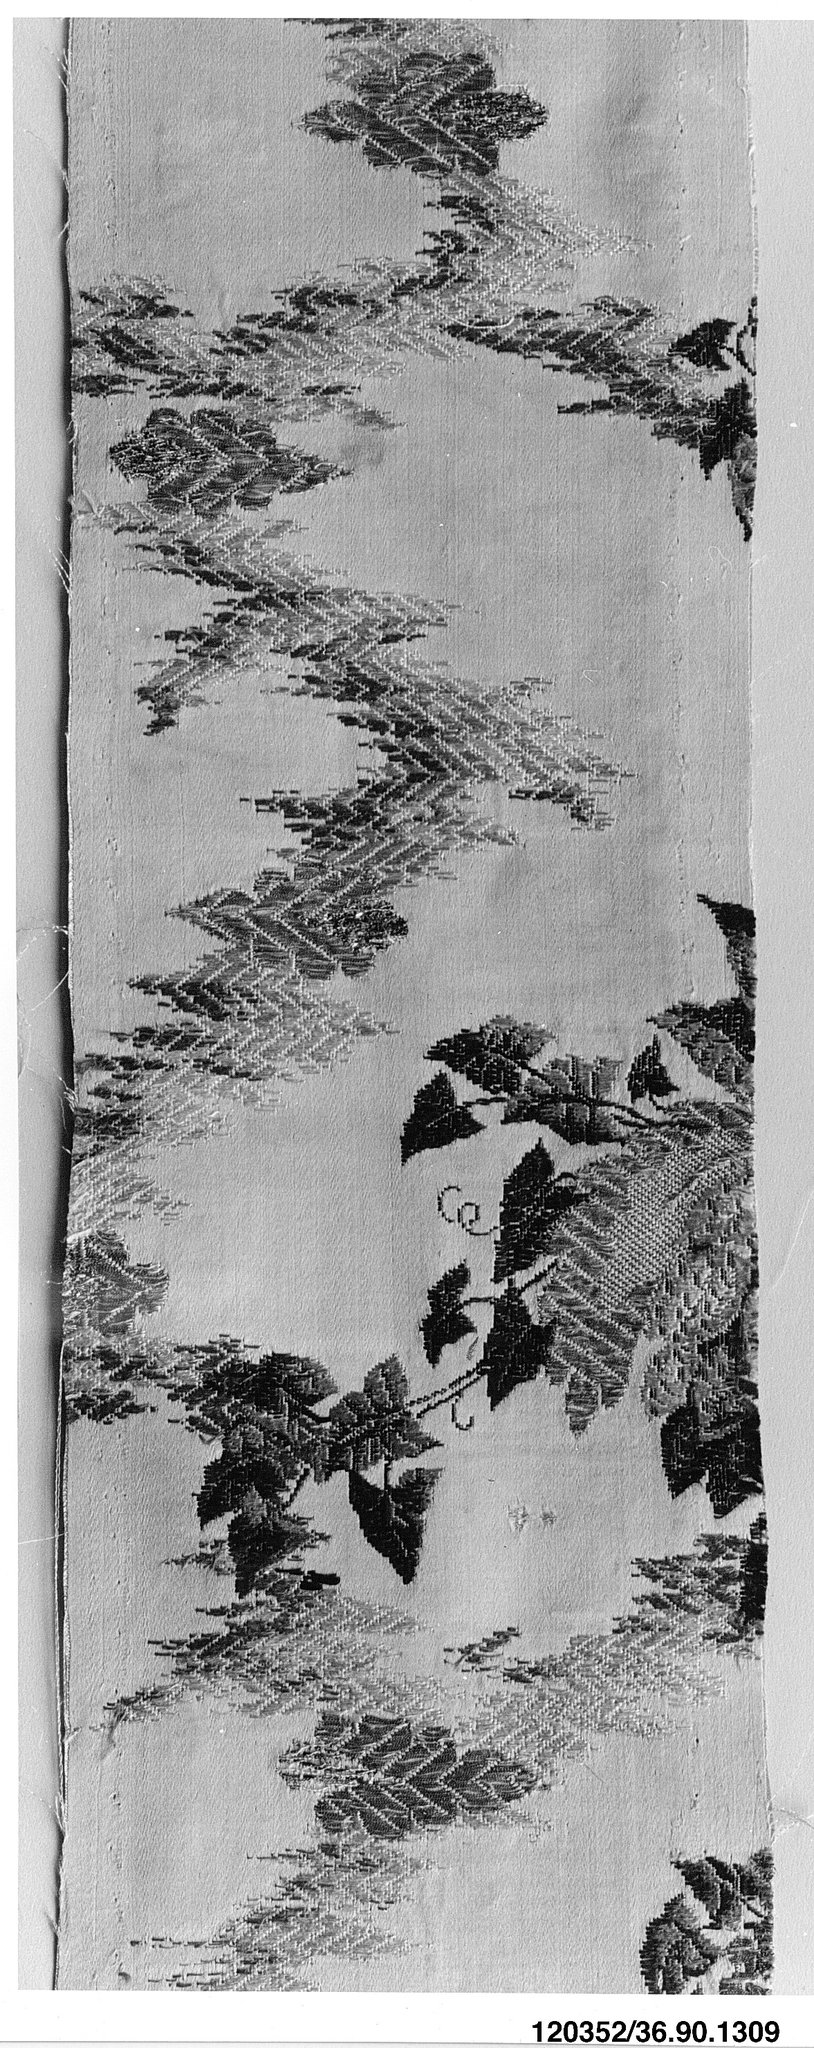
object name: piece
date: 1750-1760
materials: metal thread, silk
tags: leaves